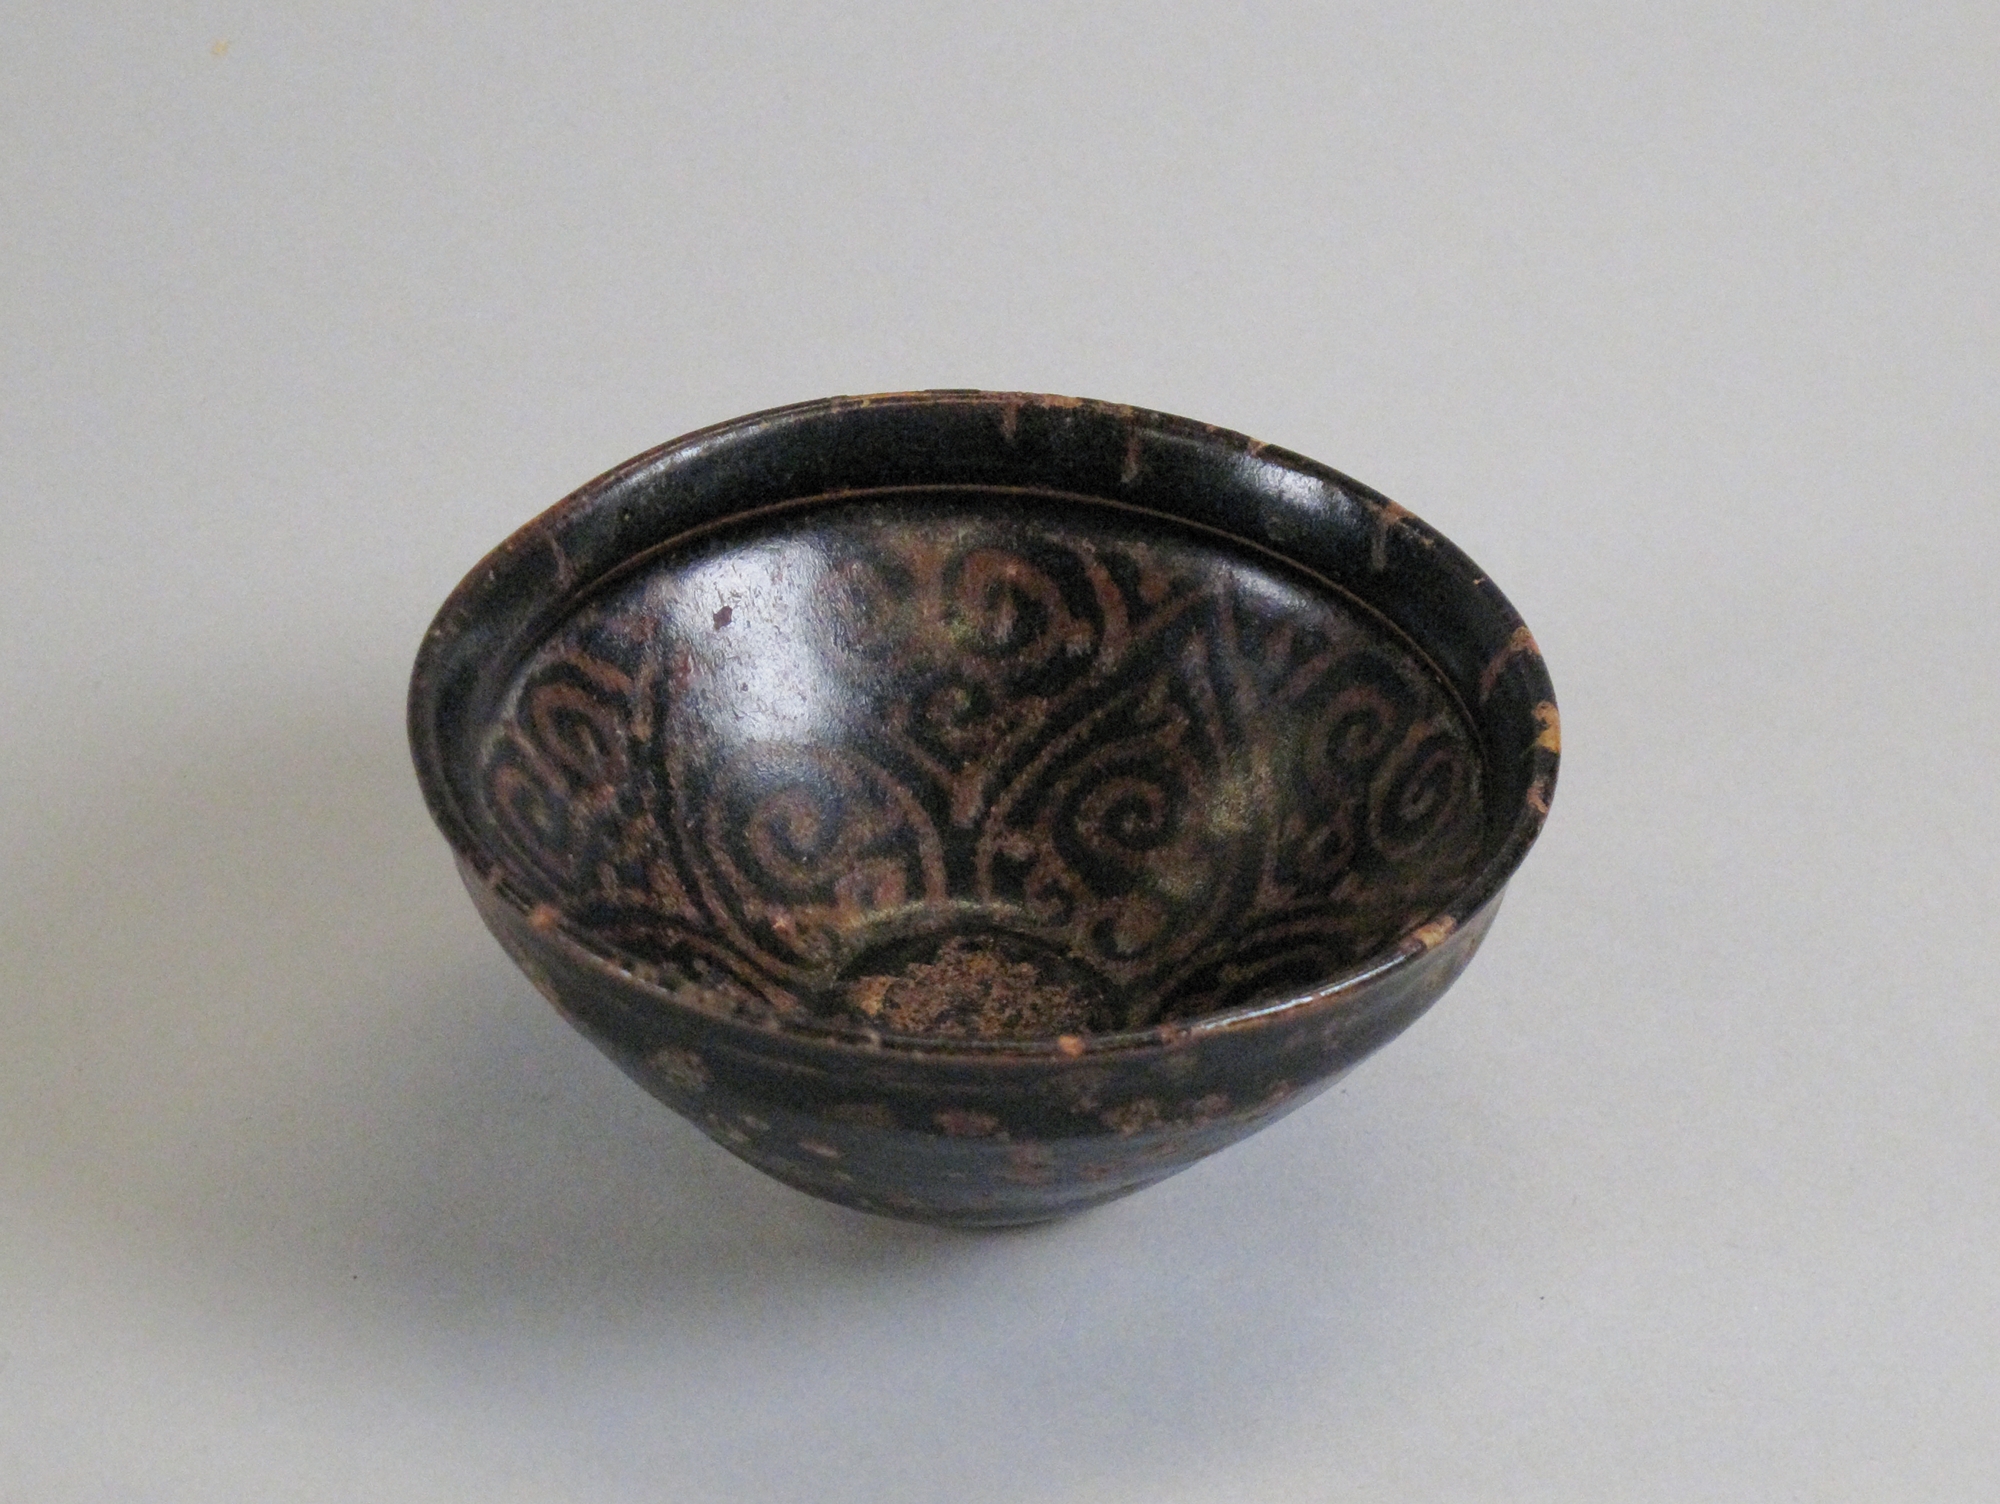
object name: bowl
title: Tea Bowl with Abstract Scroll Design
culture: chinese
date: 1201-1400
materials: glaze, stoneware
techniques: painting